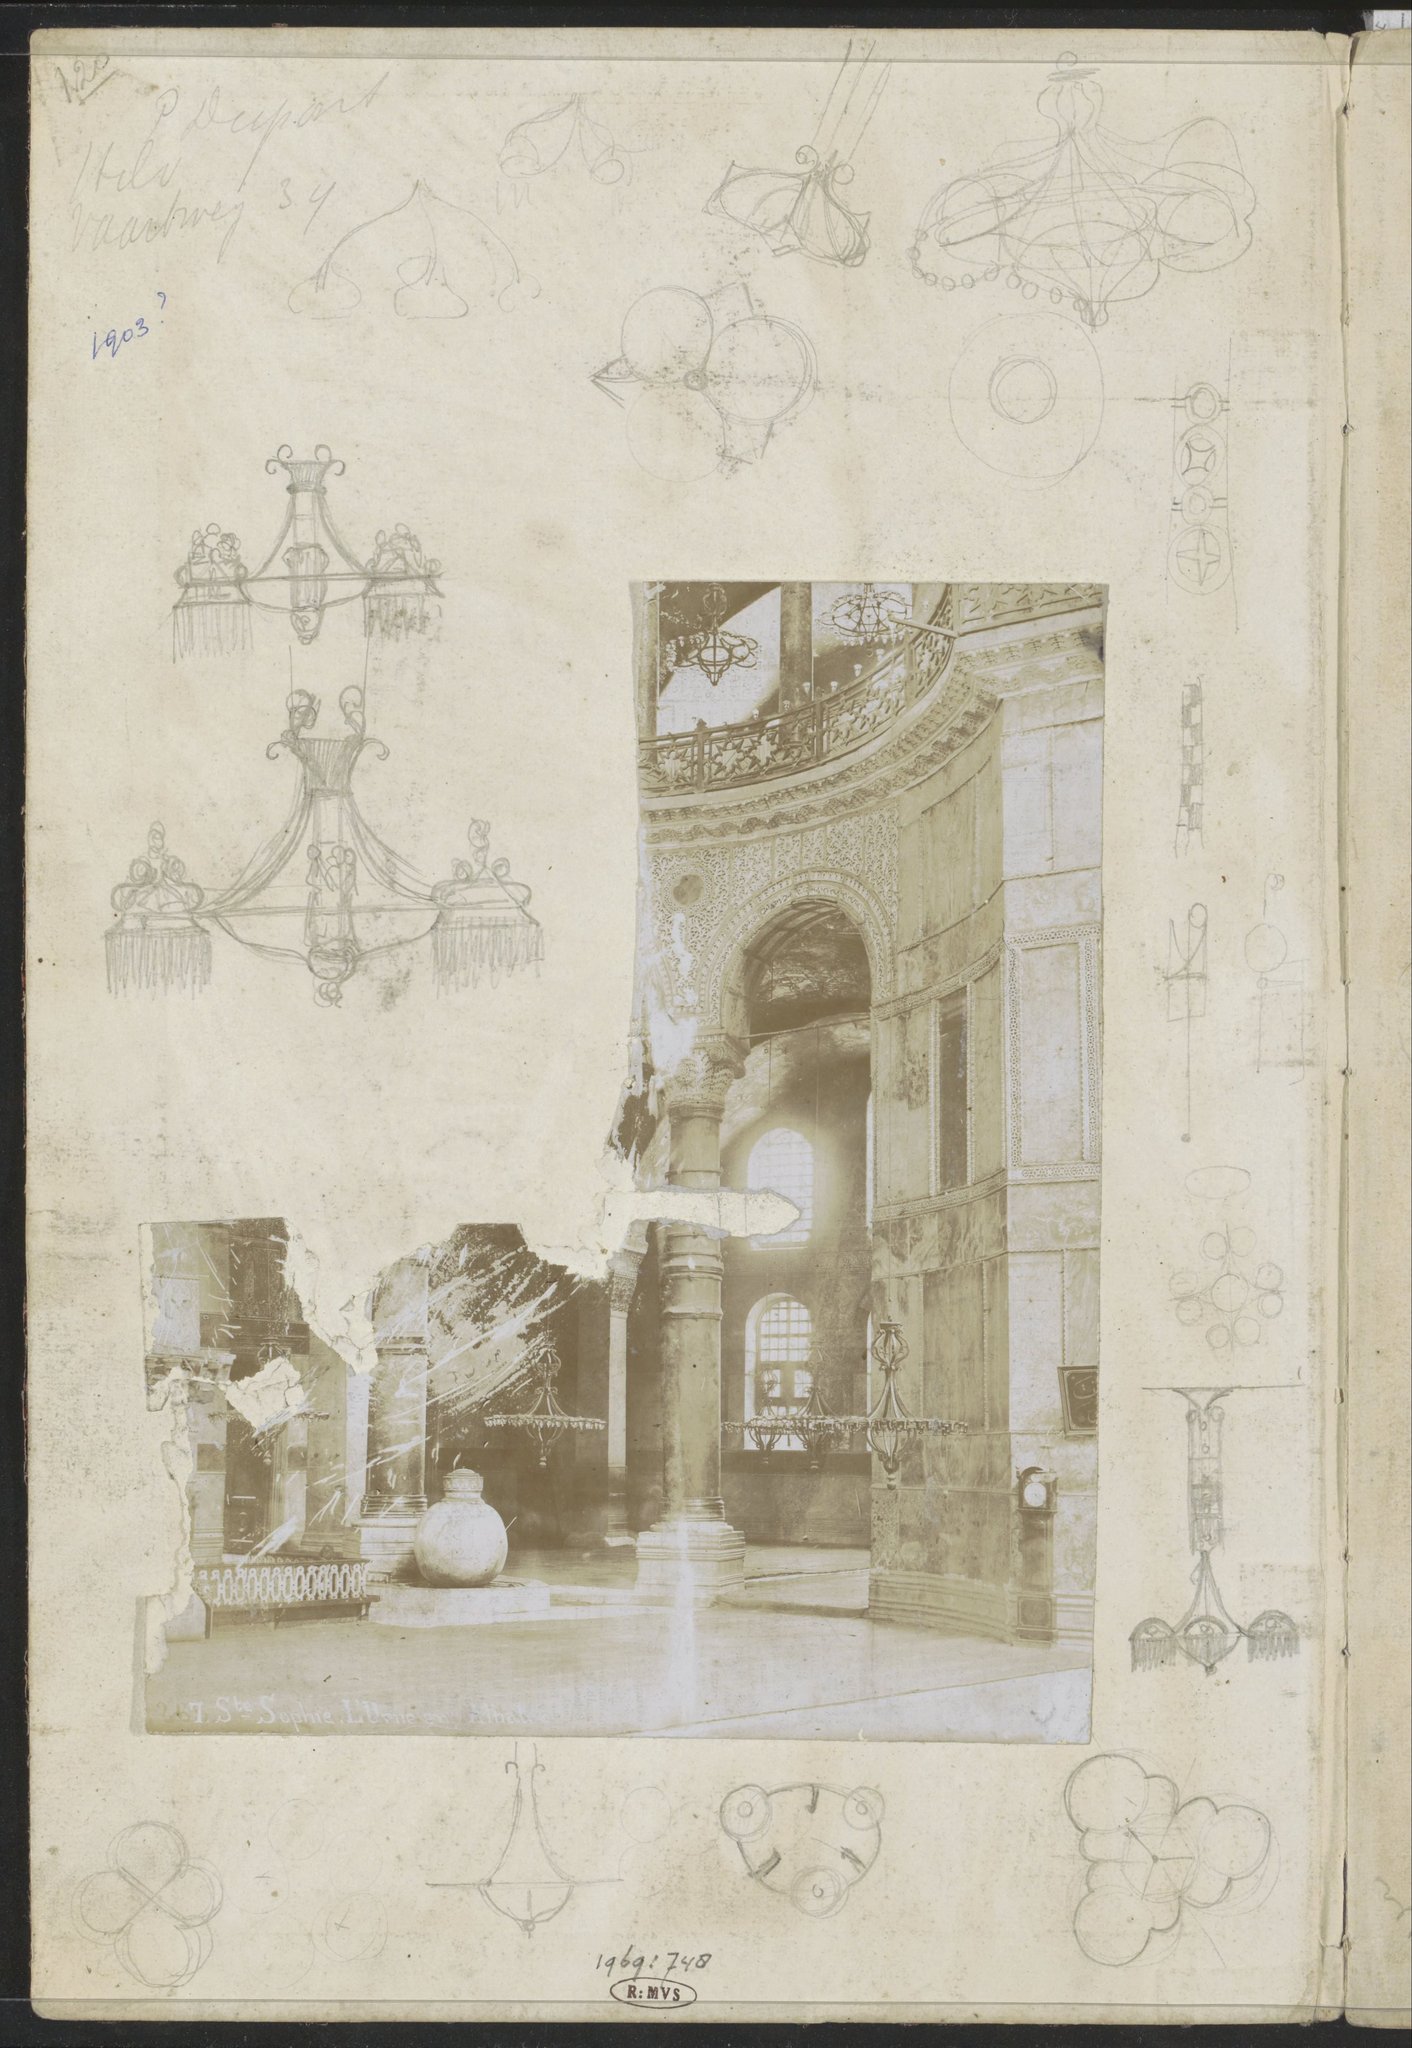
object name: endleaf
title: Kroonluchters en lampen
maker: carel adolph lion cachet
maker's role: draughtsman, print maker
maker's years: 1864-1945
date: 1903-1904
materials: paper, pencil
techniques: daylight paper print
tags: chandelier, candelabrum, interior of church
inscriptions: collector's mark: Lugt 2228a, annotation: ‘P Dupont/ Hilv/ Vaartweg 34’, annotation: ‘267 Ste Sophie L'Urne en Albal[...]’, date: ‘1903?’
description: Tevens een foto van een kerkinterieur. Voorste schutblad uit een schetsboek met 17 bladen.